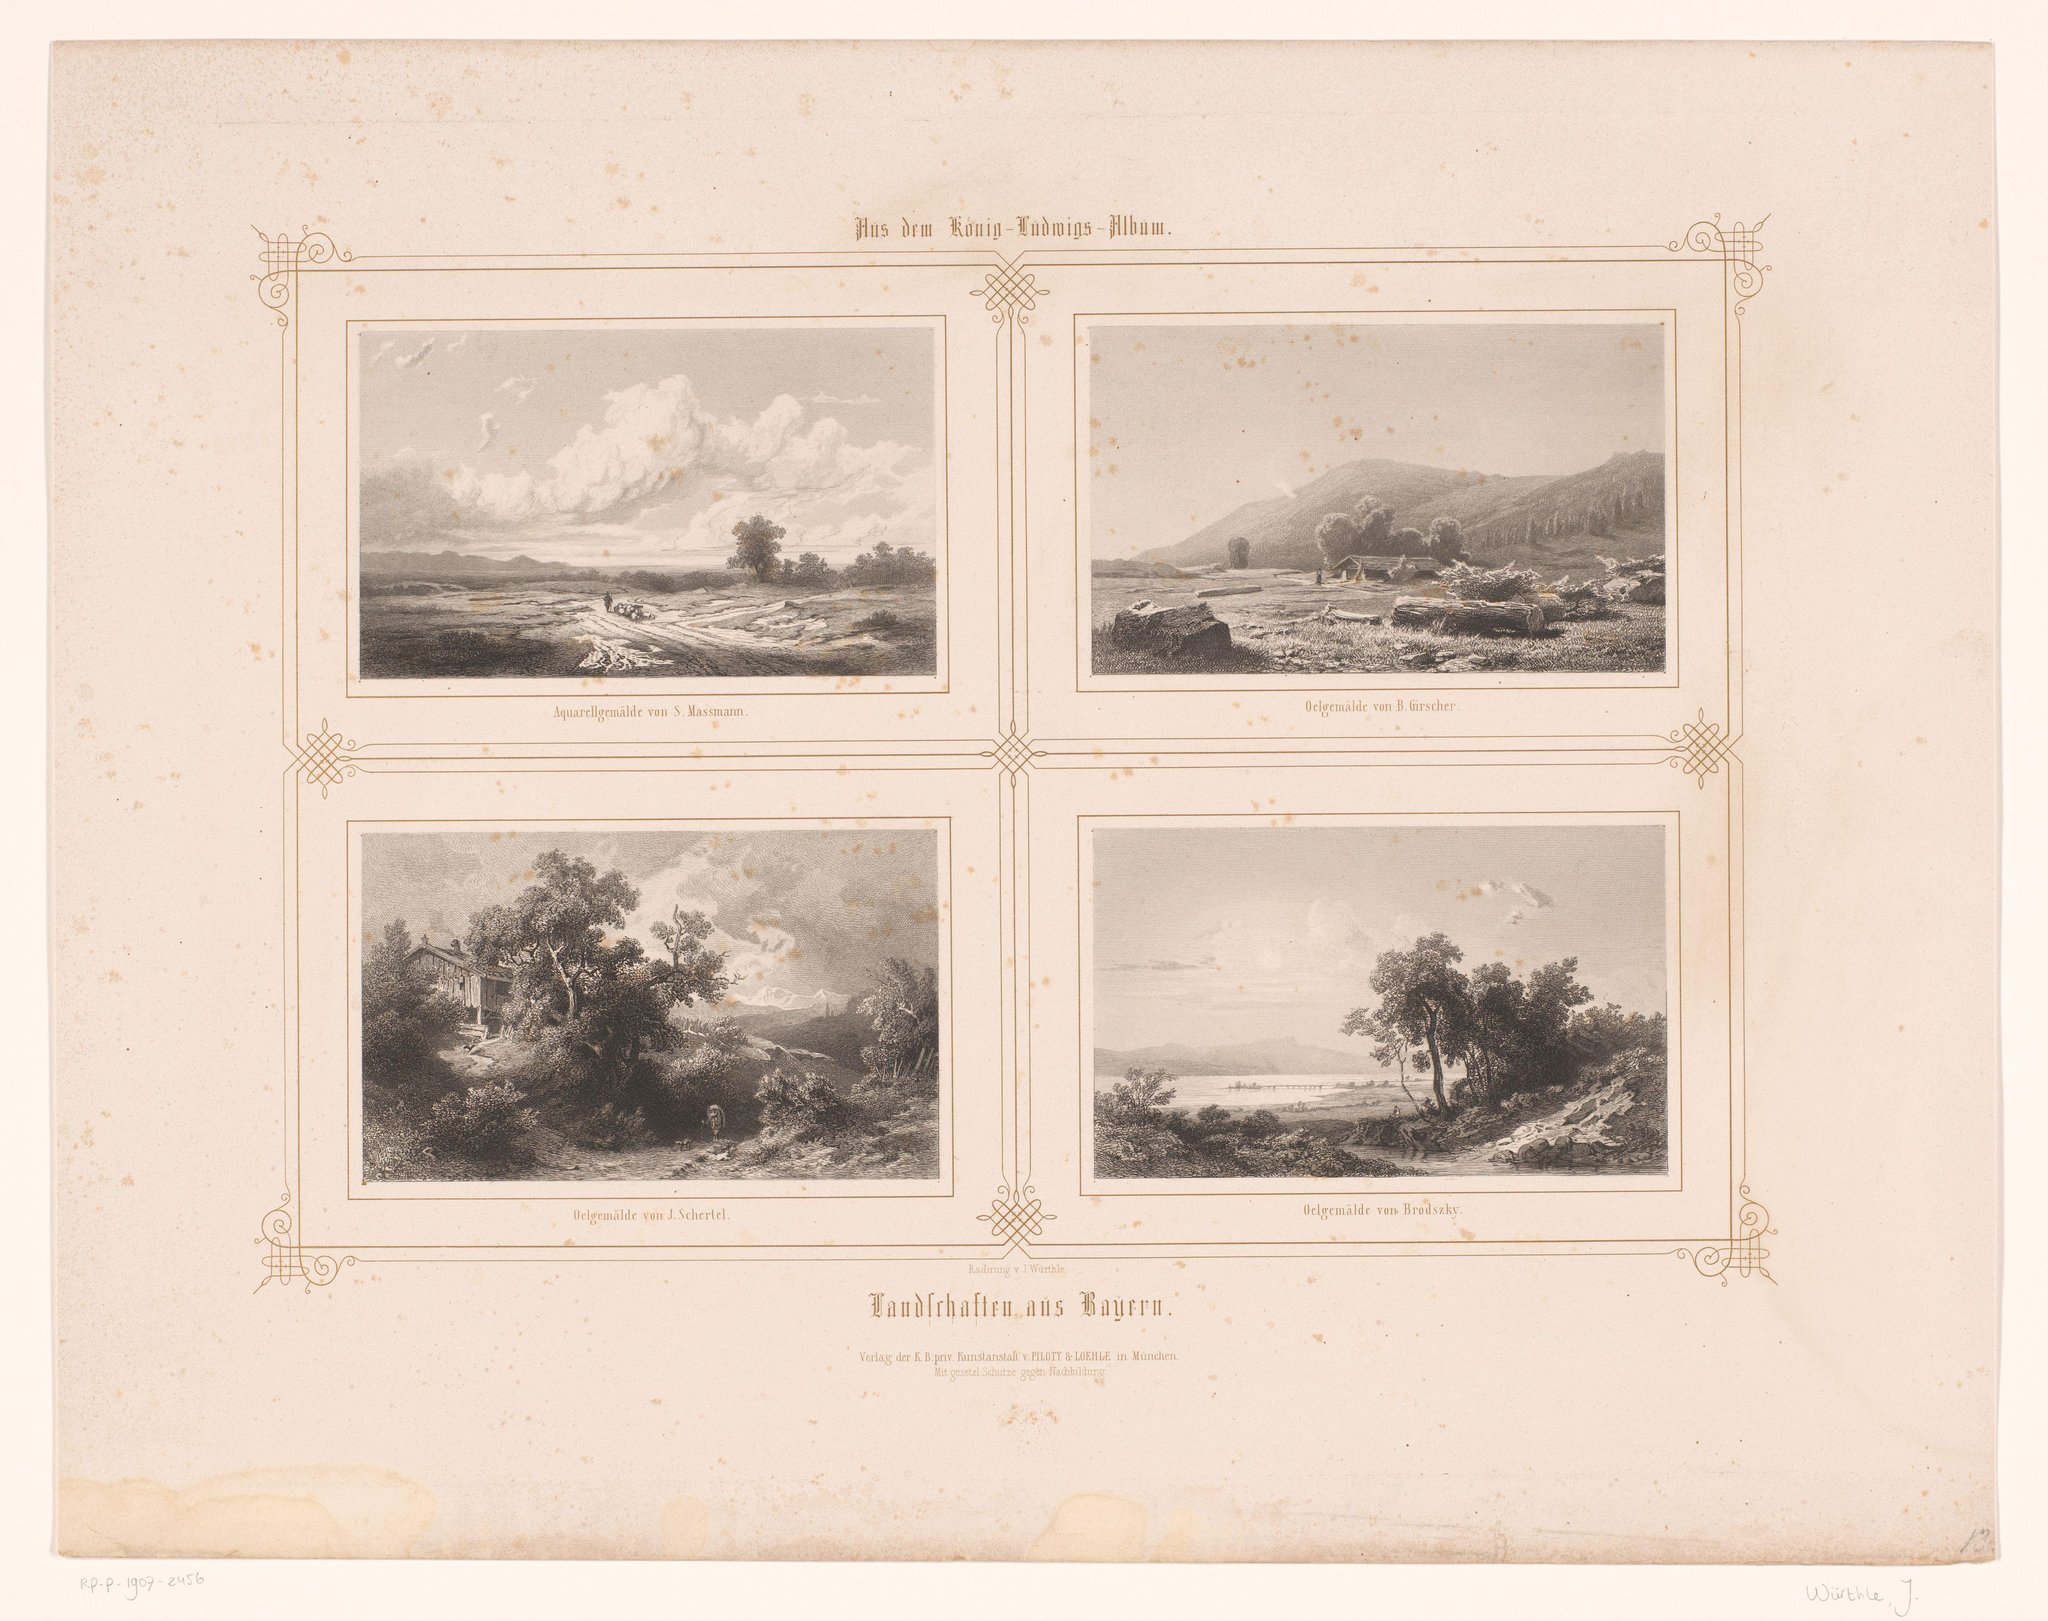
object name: print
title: König-Ludwigs Album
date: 1869-1907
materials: paper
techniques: lithograph, roulette, engraving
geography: germany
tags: lodewijk i (koning van beieren), landscapes, lake, 'en route', traveller under way, mountains, germany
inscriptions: collector's mark: Lugt 2228, check stamp: ‘Piloty & Loehle München’